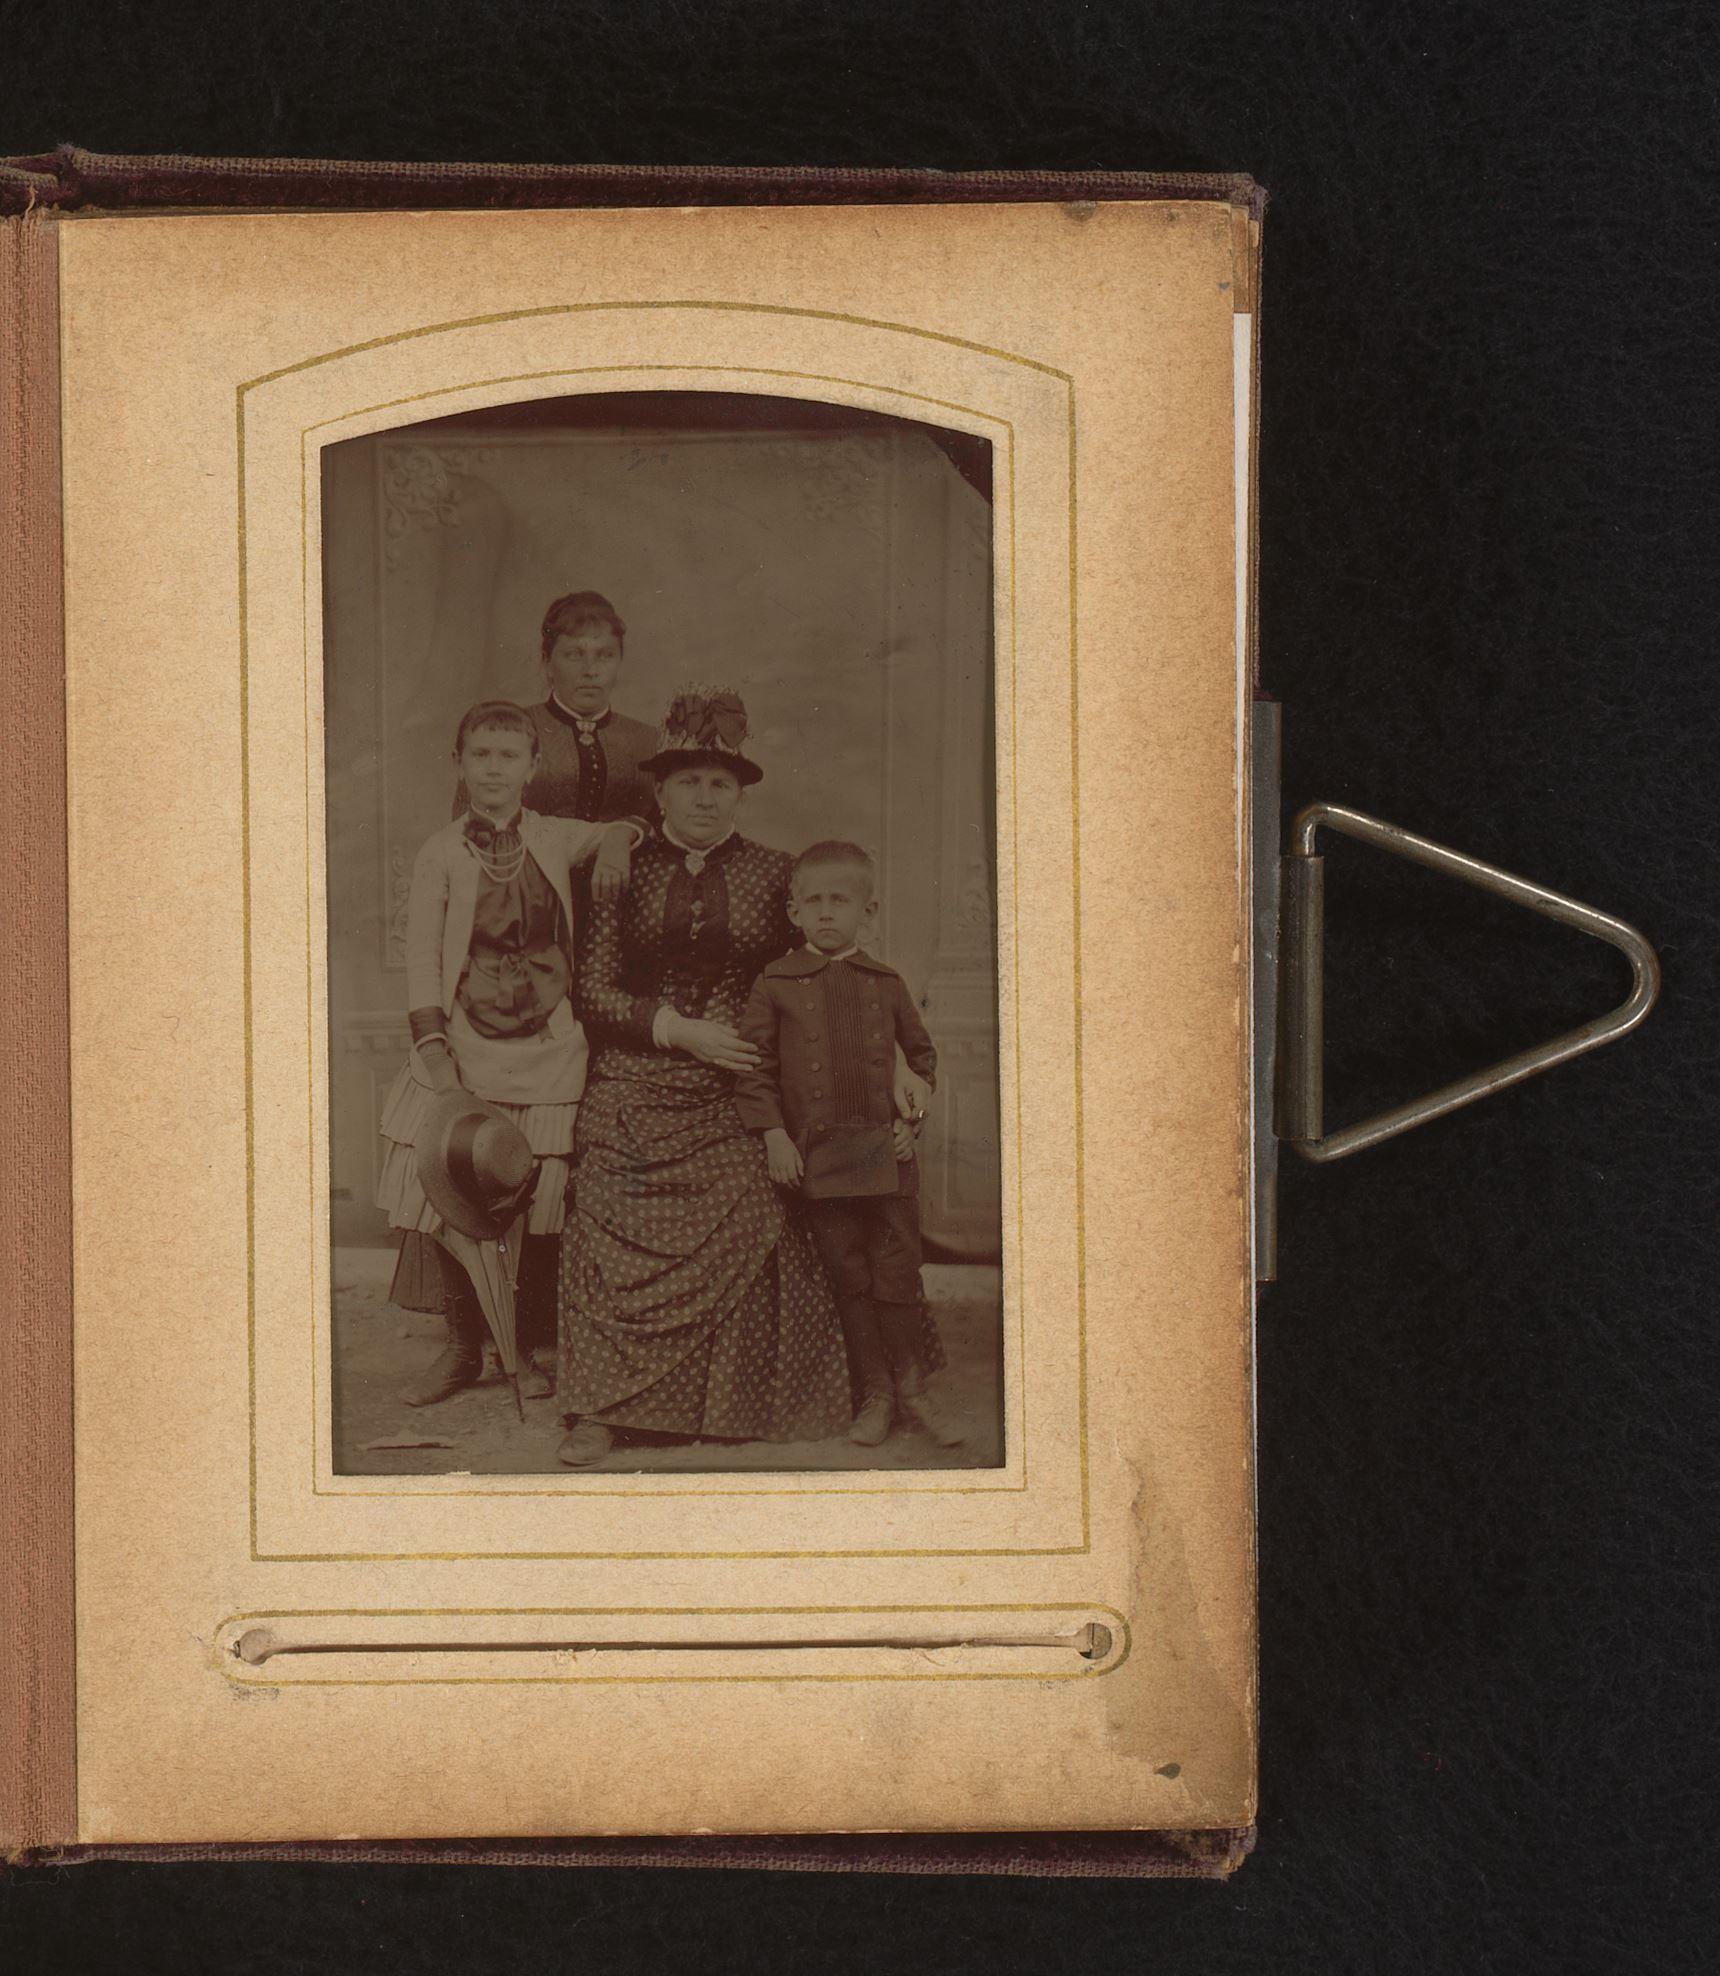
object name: album leaf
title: Portret van twee vrouwen met kinderen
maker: Anonymous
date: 1870-1882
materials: iron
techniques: ferrotyping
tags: adult woman, child, historical persons